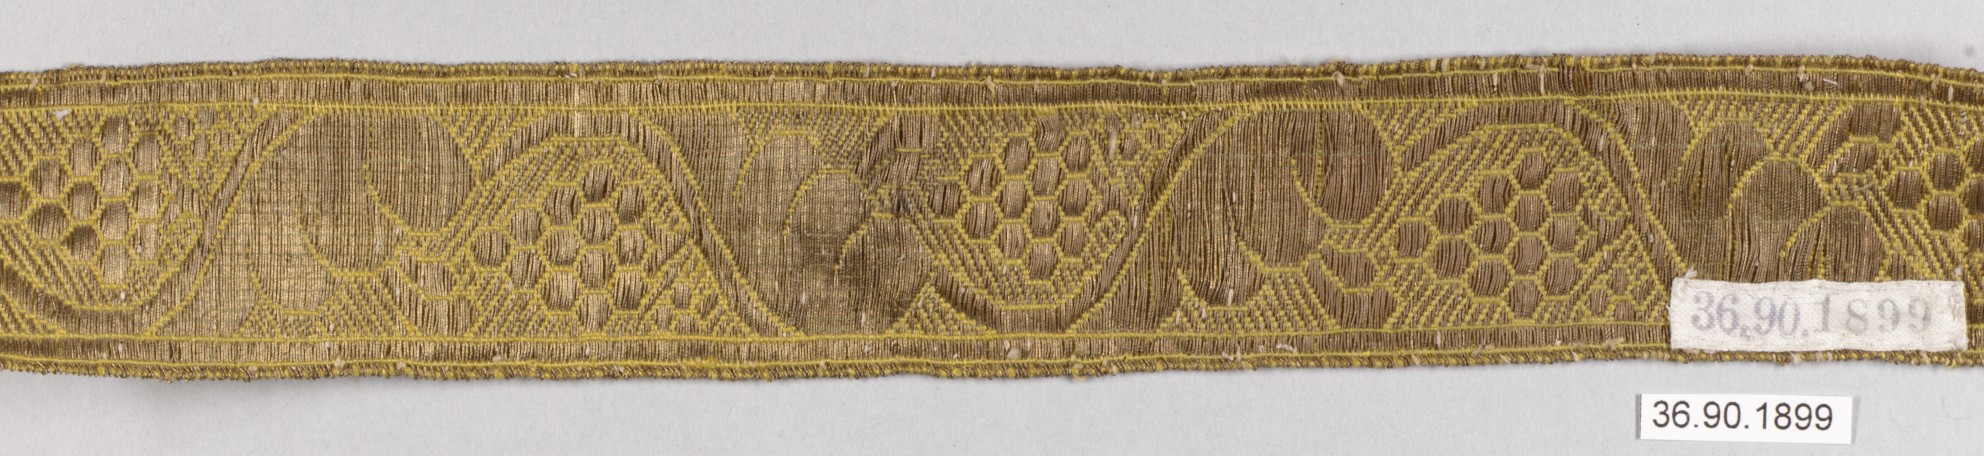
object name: galloon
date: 1767-1833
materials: metal thread, silk